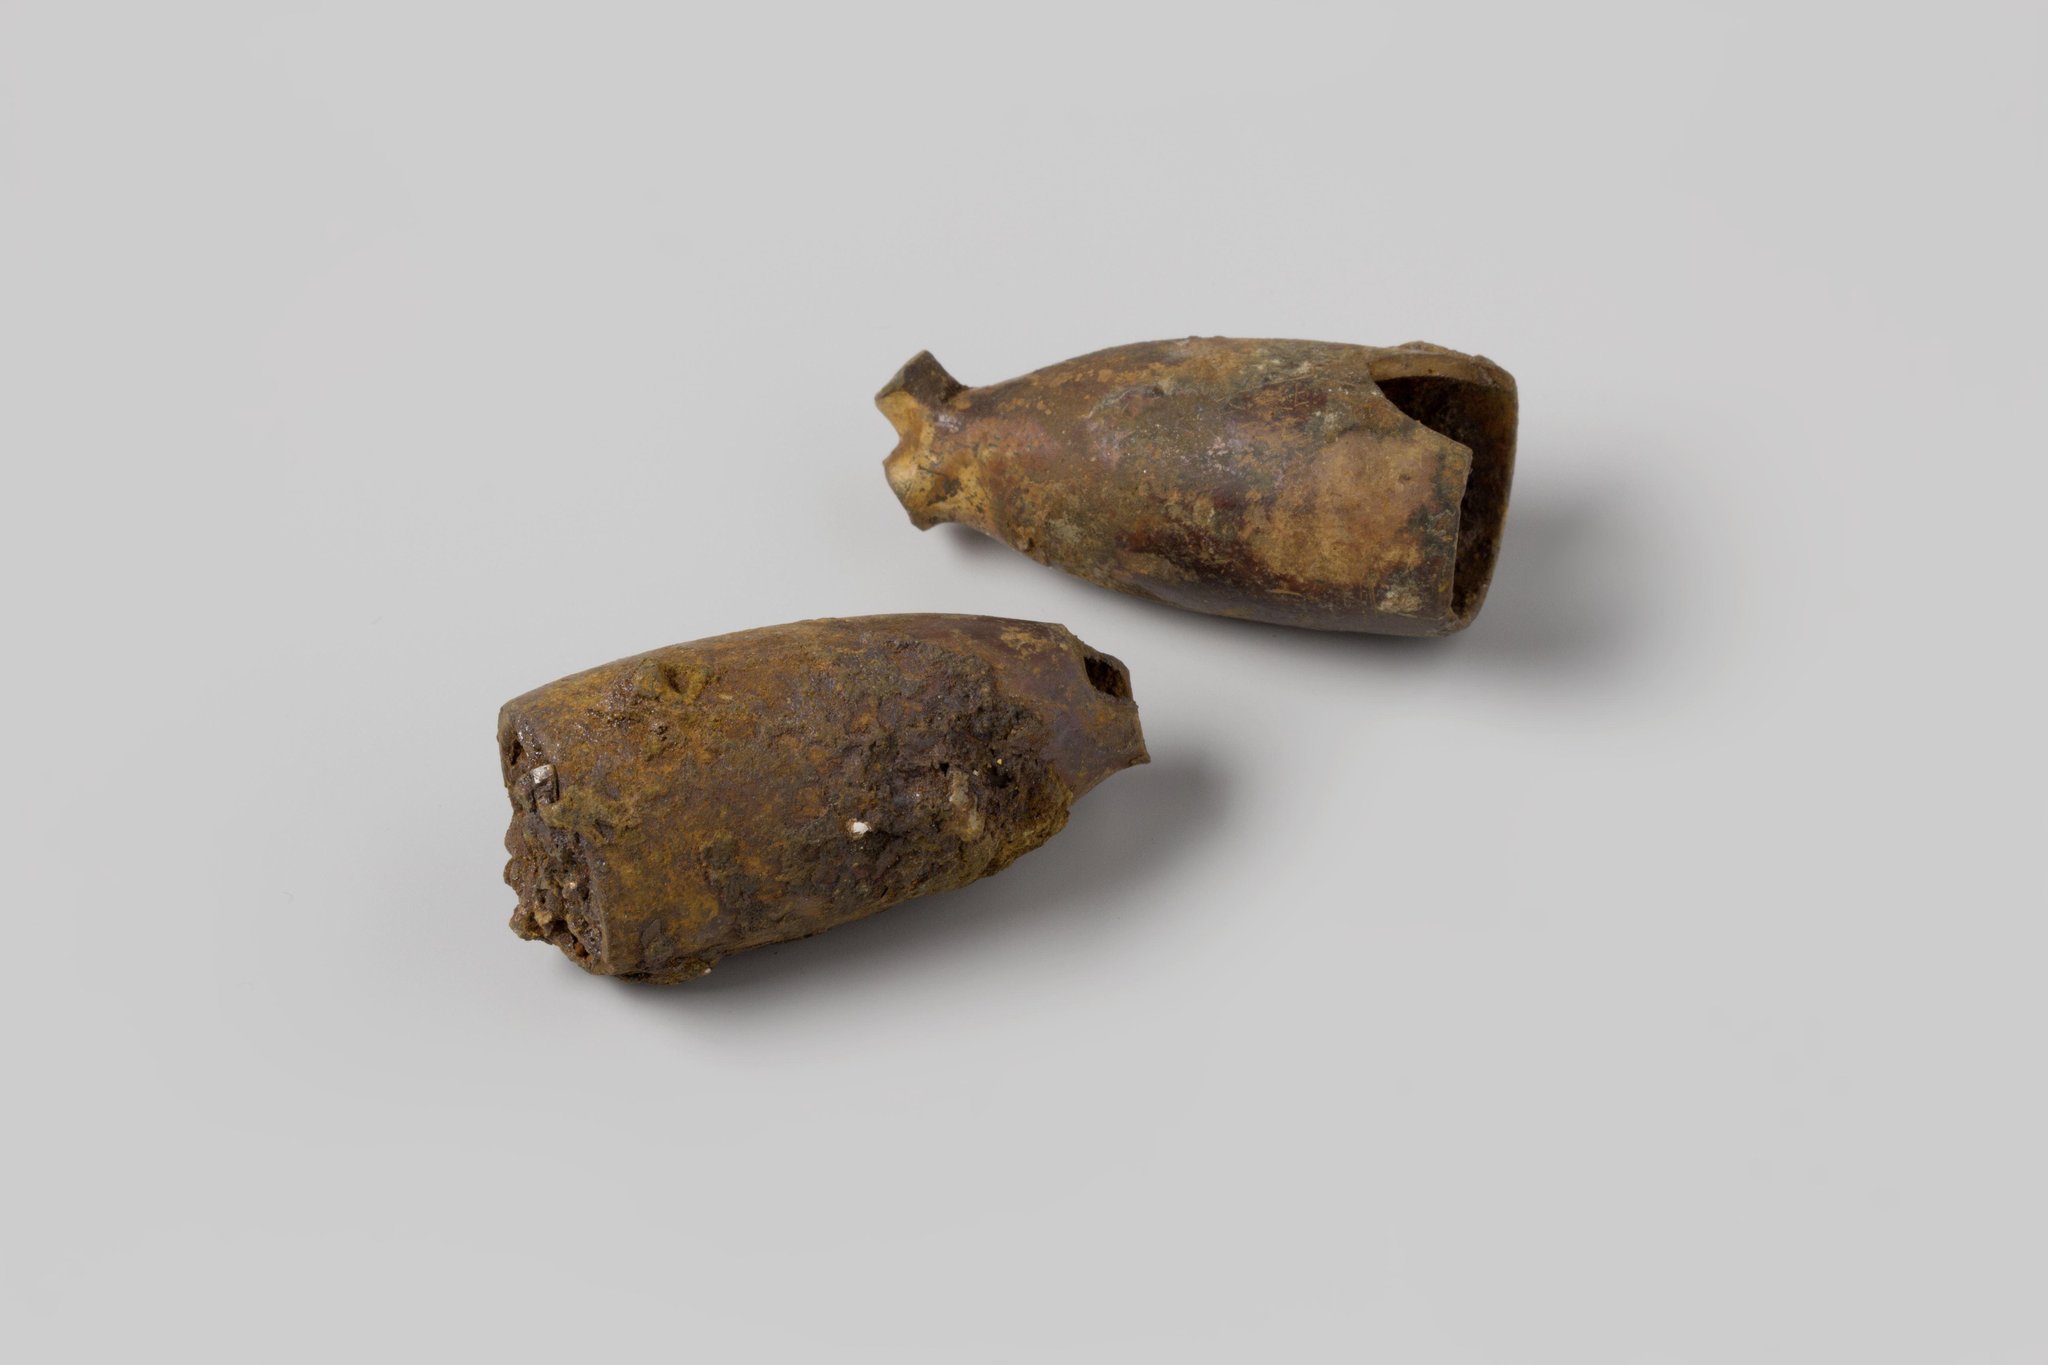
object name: pipe bowl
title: Fragmenten pijpenkoppen uit het wrak van de Oost-Indiëvaarder Hollandia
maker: Anonymous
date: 1700-1743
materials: stone, clay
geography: netherlands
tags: verenigde oostindische compagnie, hollandia (schip), annet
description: Pipe, bowl, heelmark illegible; fragments, no hsm.